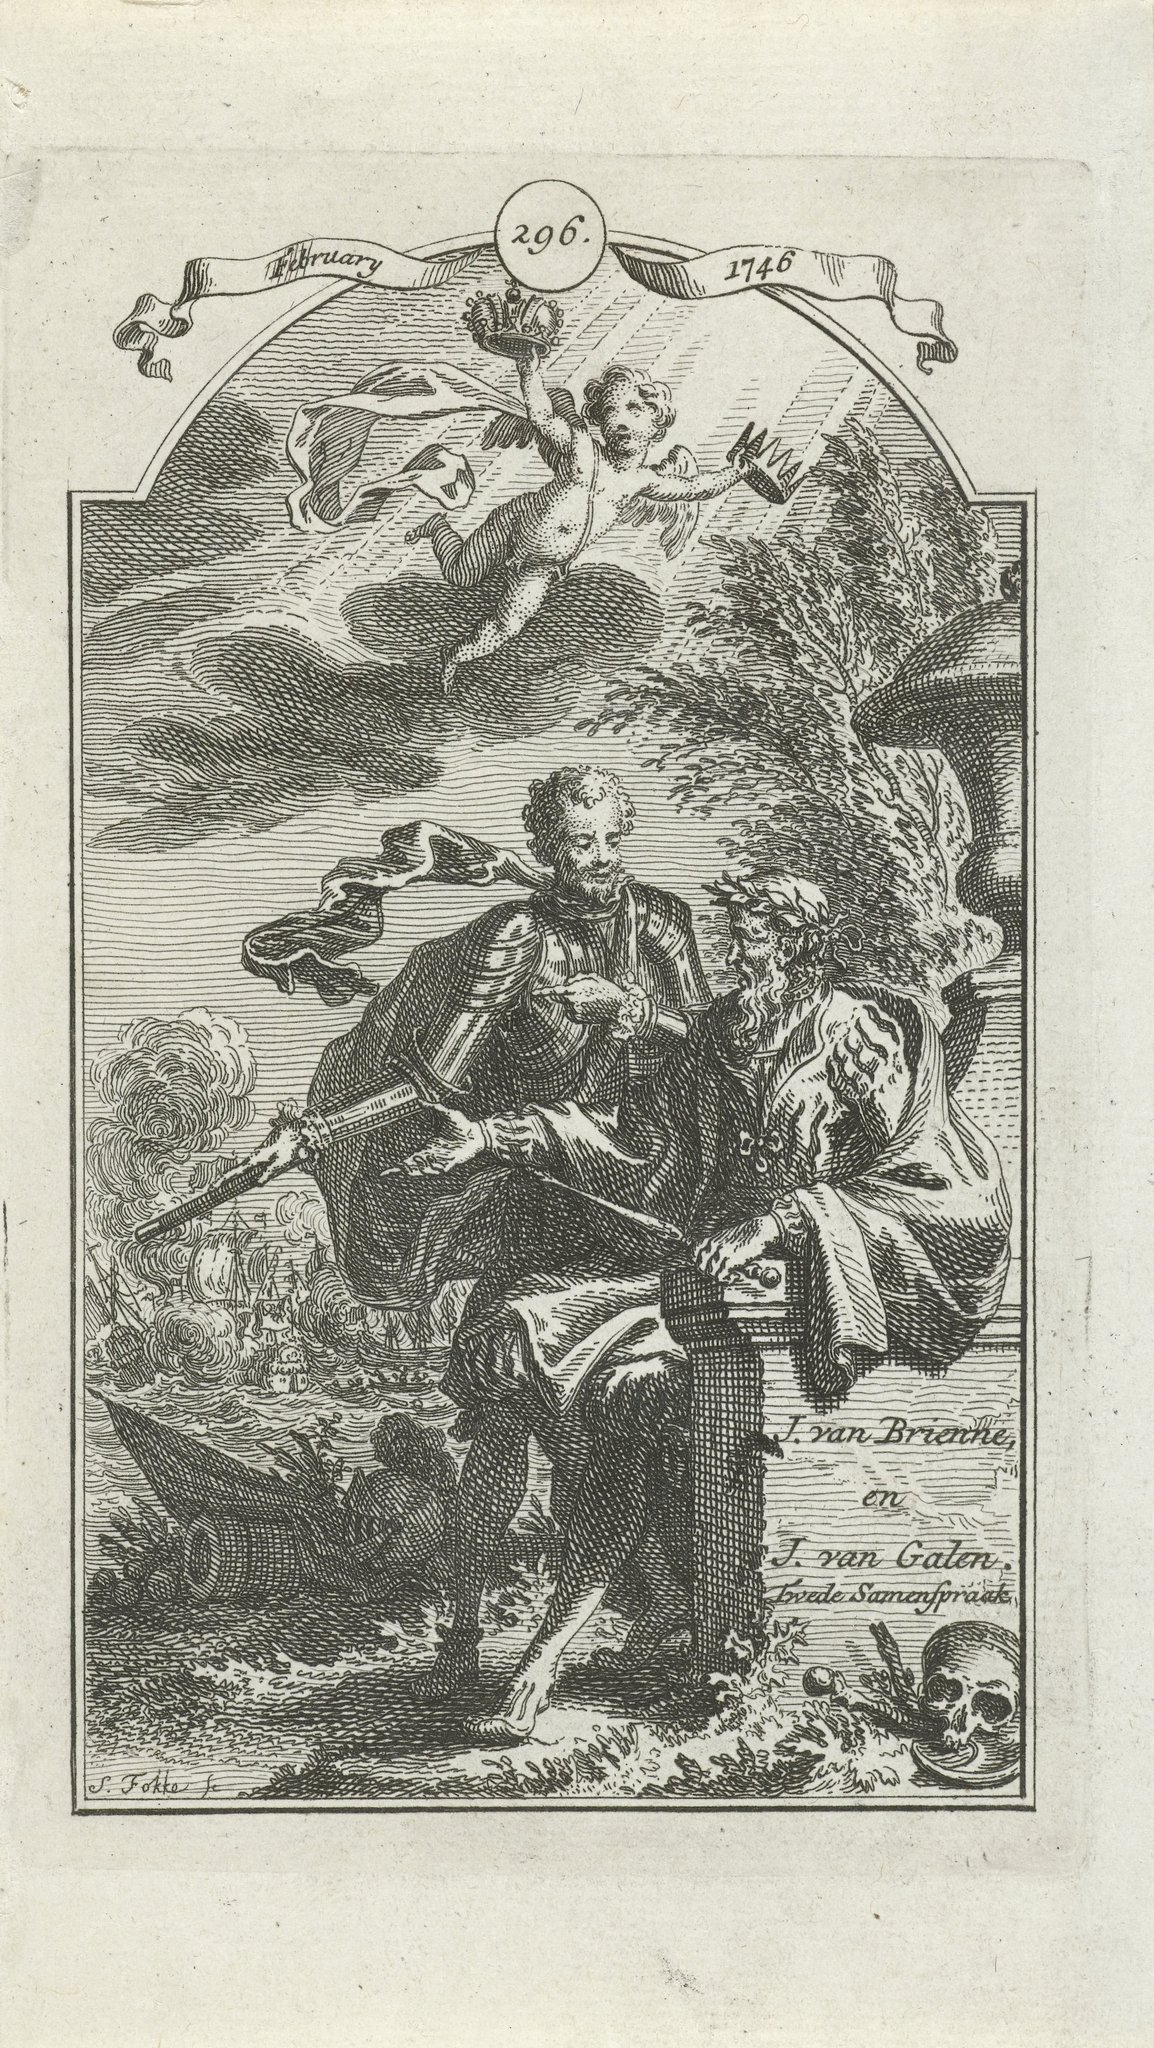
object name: print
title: Twee historische figuren in gesprek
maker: simon fokke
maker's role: draughtsman, print maker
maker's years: 1712-1784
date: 1722-1784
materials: paper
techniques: etching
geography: amsterdam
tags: essen, crown (symbol of sovereignty), cupids: 'amores', 'amoretti', 'putti'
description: Jan van Brienne (met laurierkrans op het hoofd) en Johan van Galen in de buitenlucht in gesprek. Hierboven vliegt een putto met twee kronen in de hand. Op de achtergrond is een zeeslag afgebeeld. Boven de afbeelding de datum februari 1746 met het nummer 296.